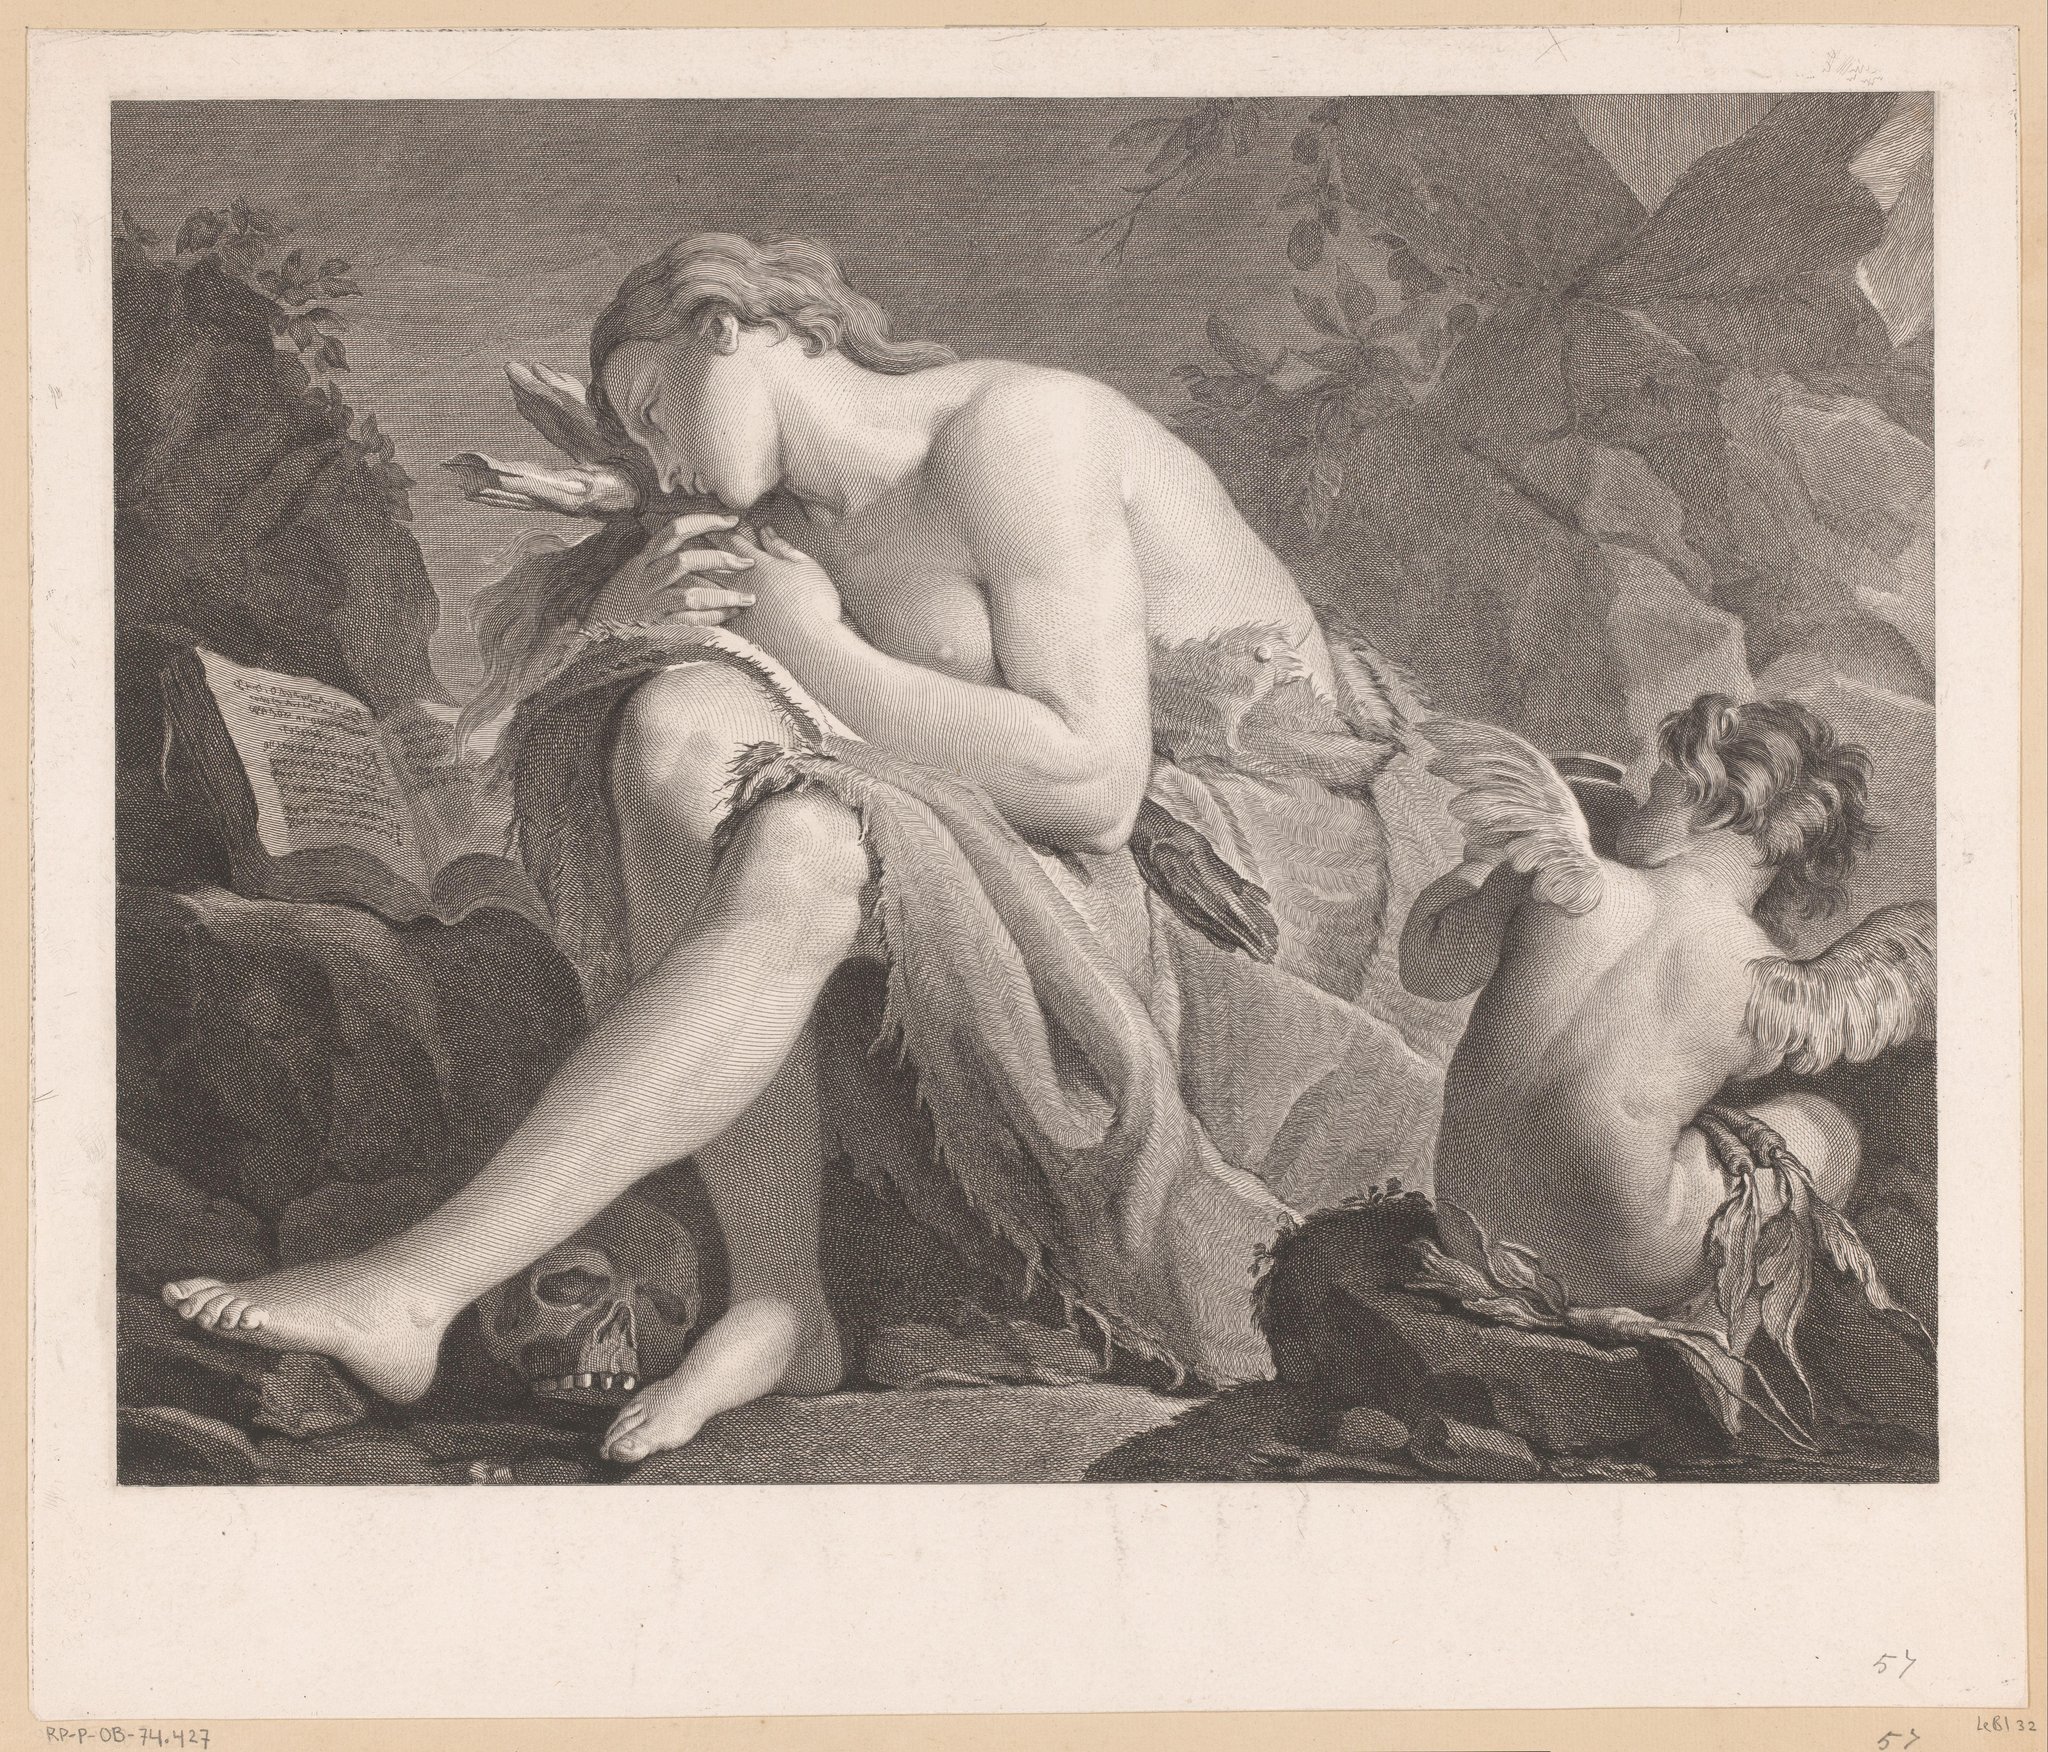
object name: print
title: Maria Magdalena in de wildernis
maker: jacques nicolas tardieu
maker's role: print maker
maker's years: 1716-1791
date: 1726-1791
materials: paper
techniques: engraving, etching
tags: the penitent harlot mary magdalene; possible attributes: book (or scroll), crown, crown of thorns, crucifix, jar of ointment, mirror, musical instrument, palm-branch, rosary, scourge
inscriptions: collector's mark: Lugt 240